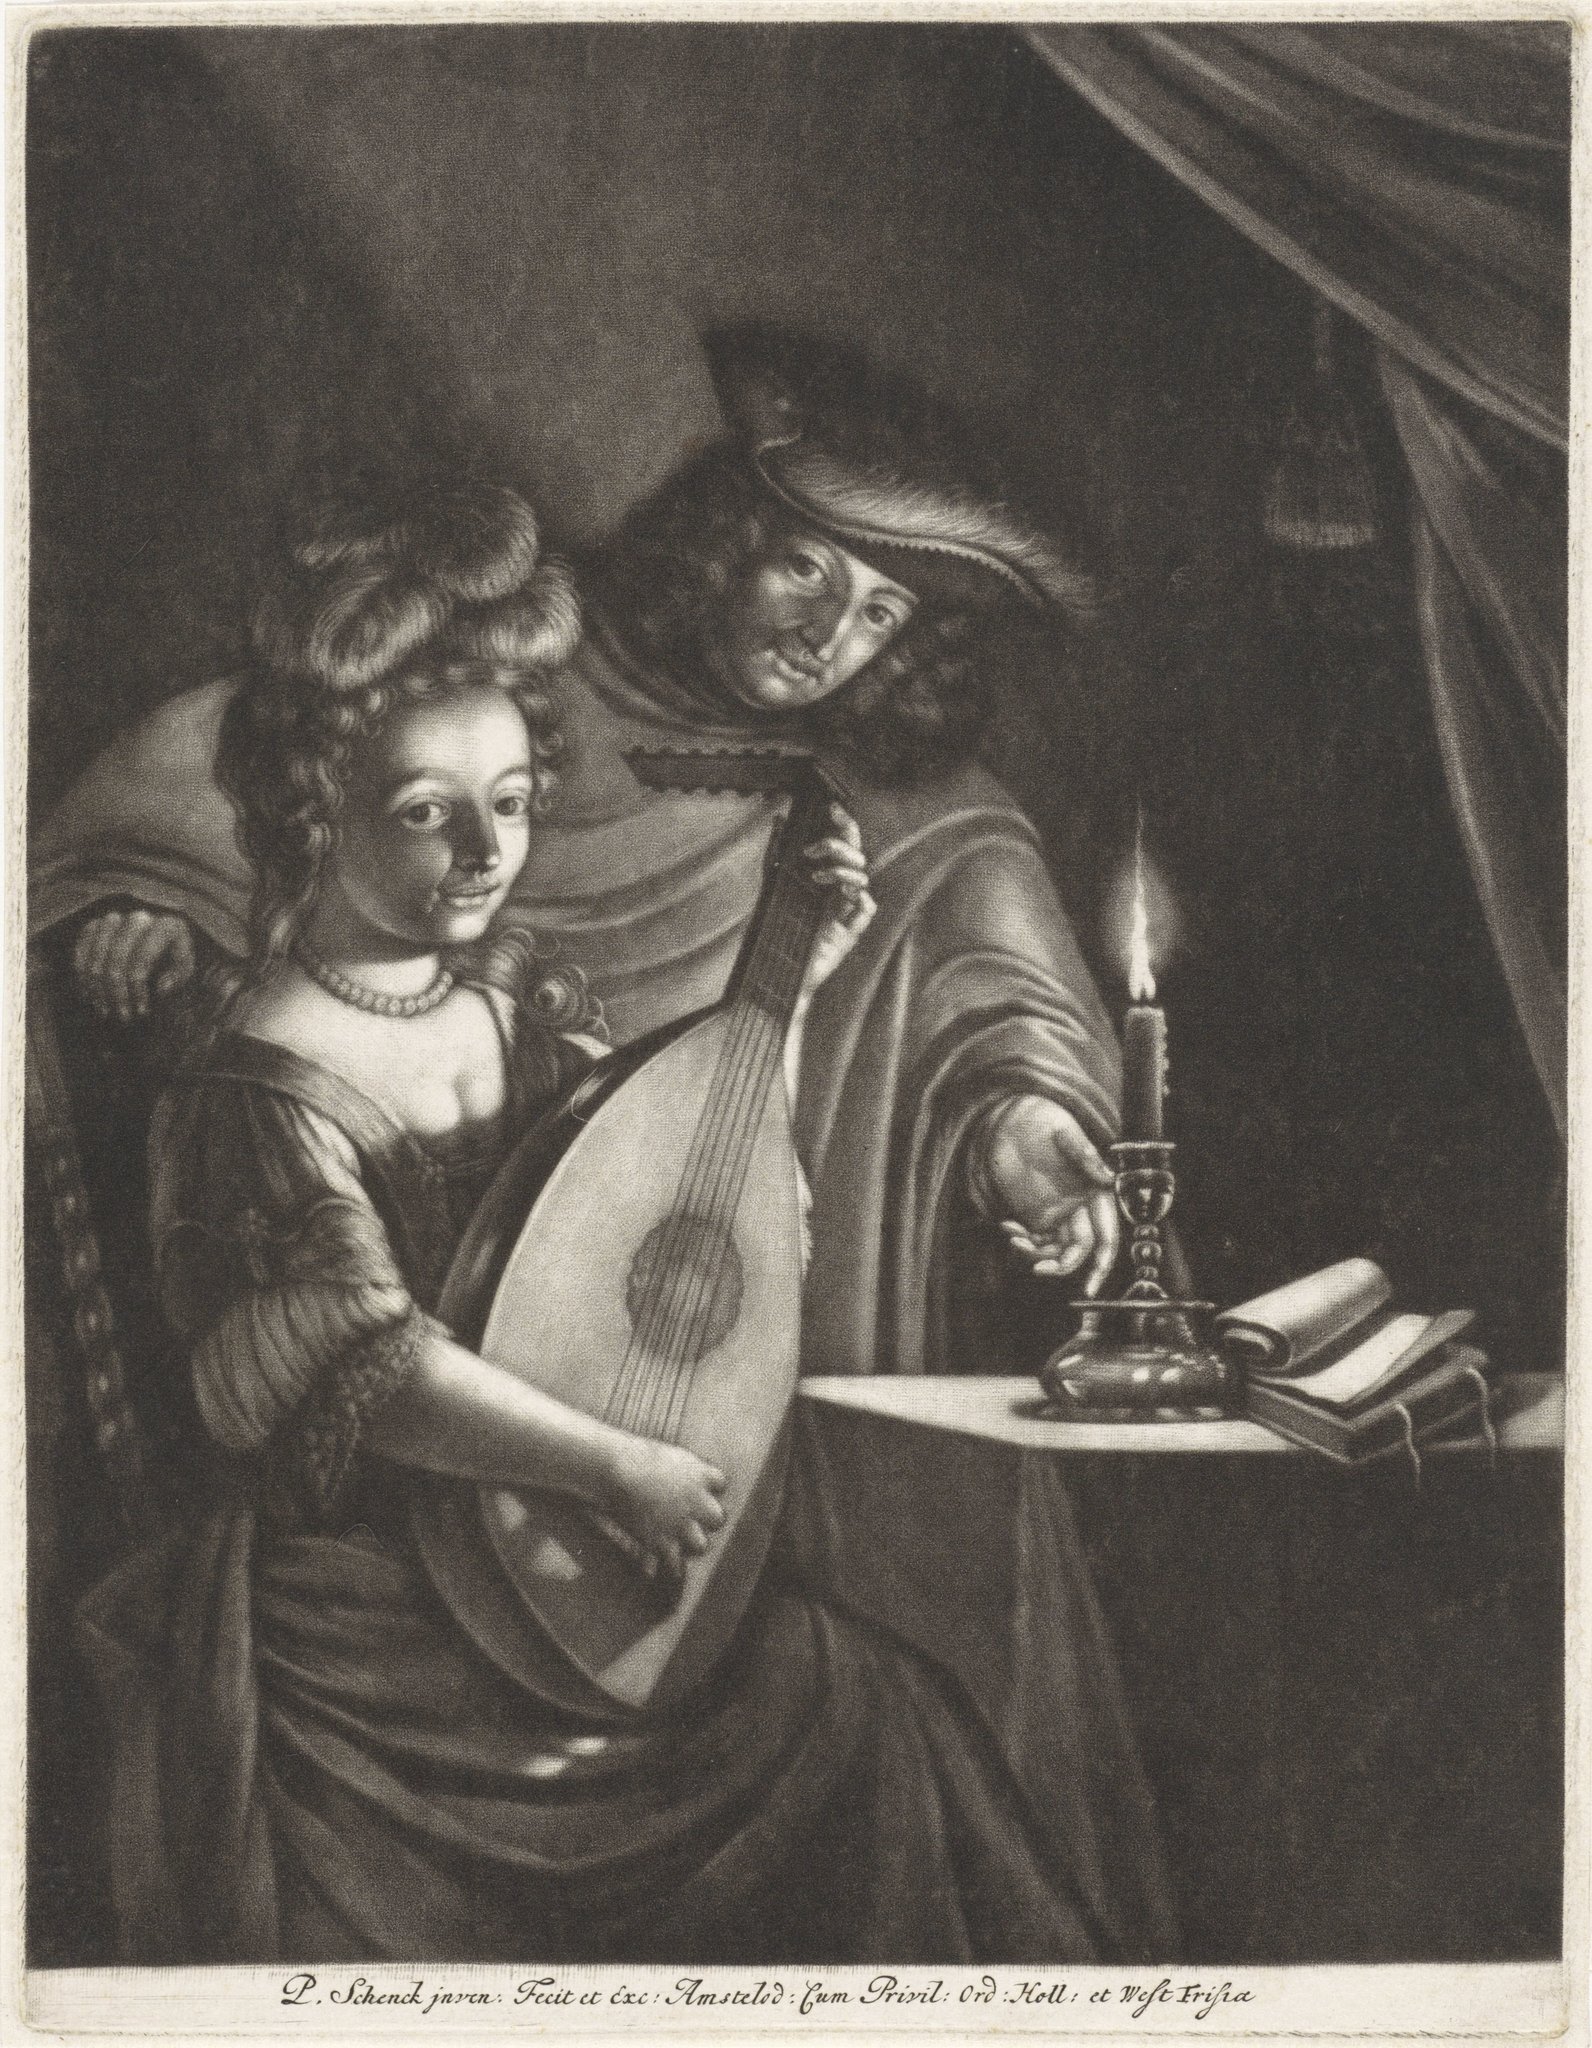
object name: print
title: Luitspeelster en jongeman bij kaarslicht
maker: pieter schenk (i)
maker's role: print maker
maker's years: 1660-1711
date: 1670-1713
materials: paper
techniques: engraving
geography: amsterdam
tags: one person playing string instrument (plucked), lute, and special forms of lute, e.g.: theorbo, candlestick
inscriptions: collector's mark: Lugt 2228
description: Een jonge vrouw, getooid met veren, speelt luit bij kaarslicht. De jongeman naast haar reikt met zijn hand naar de kaars.